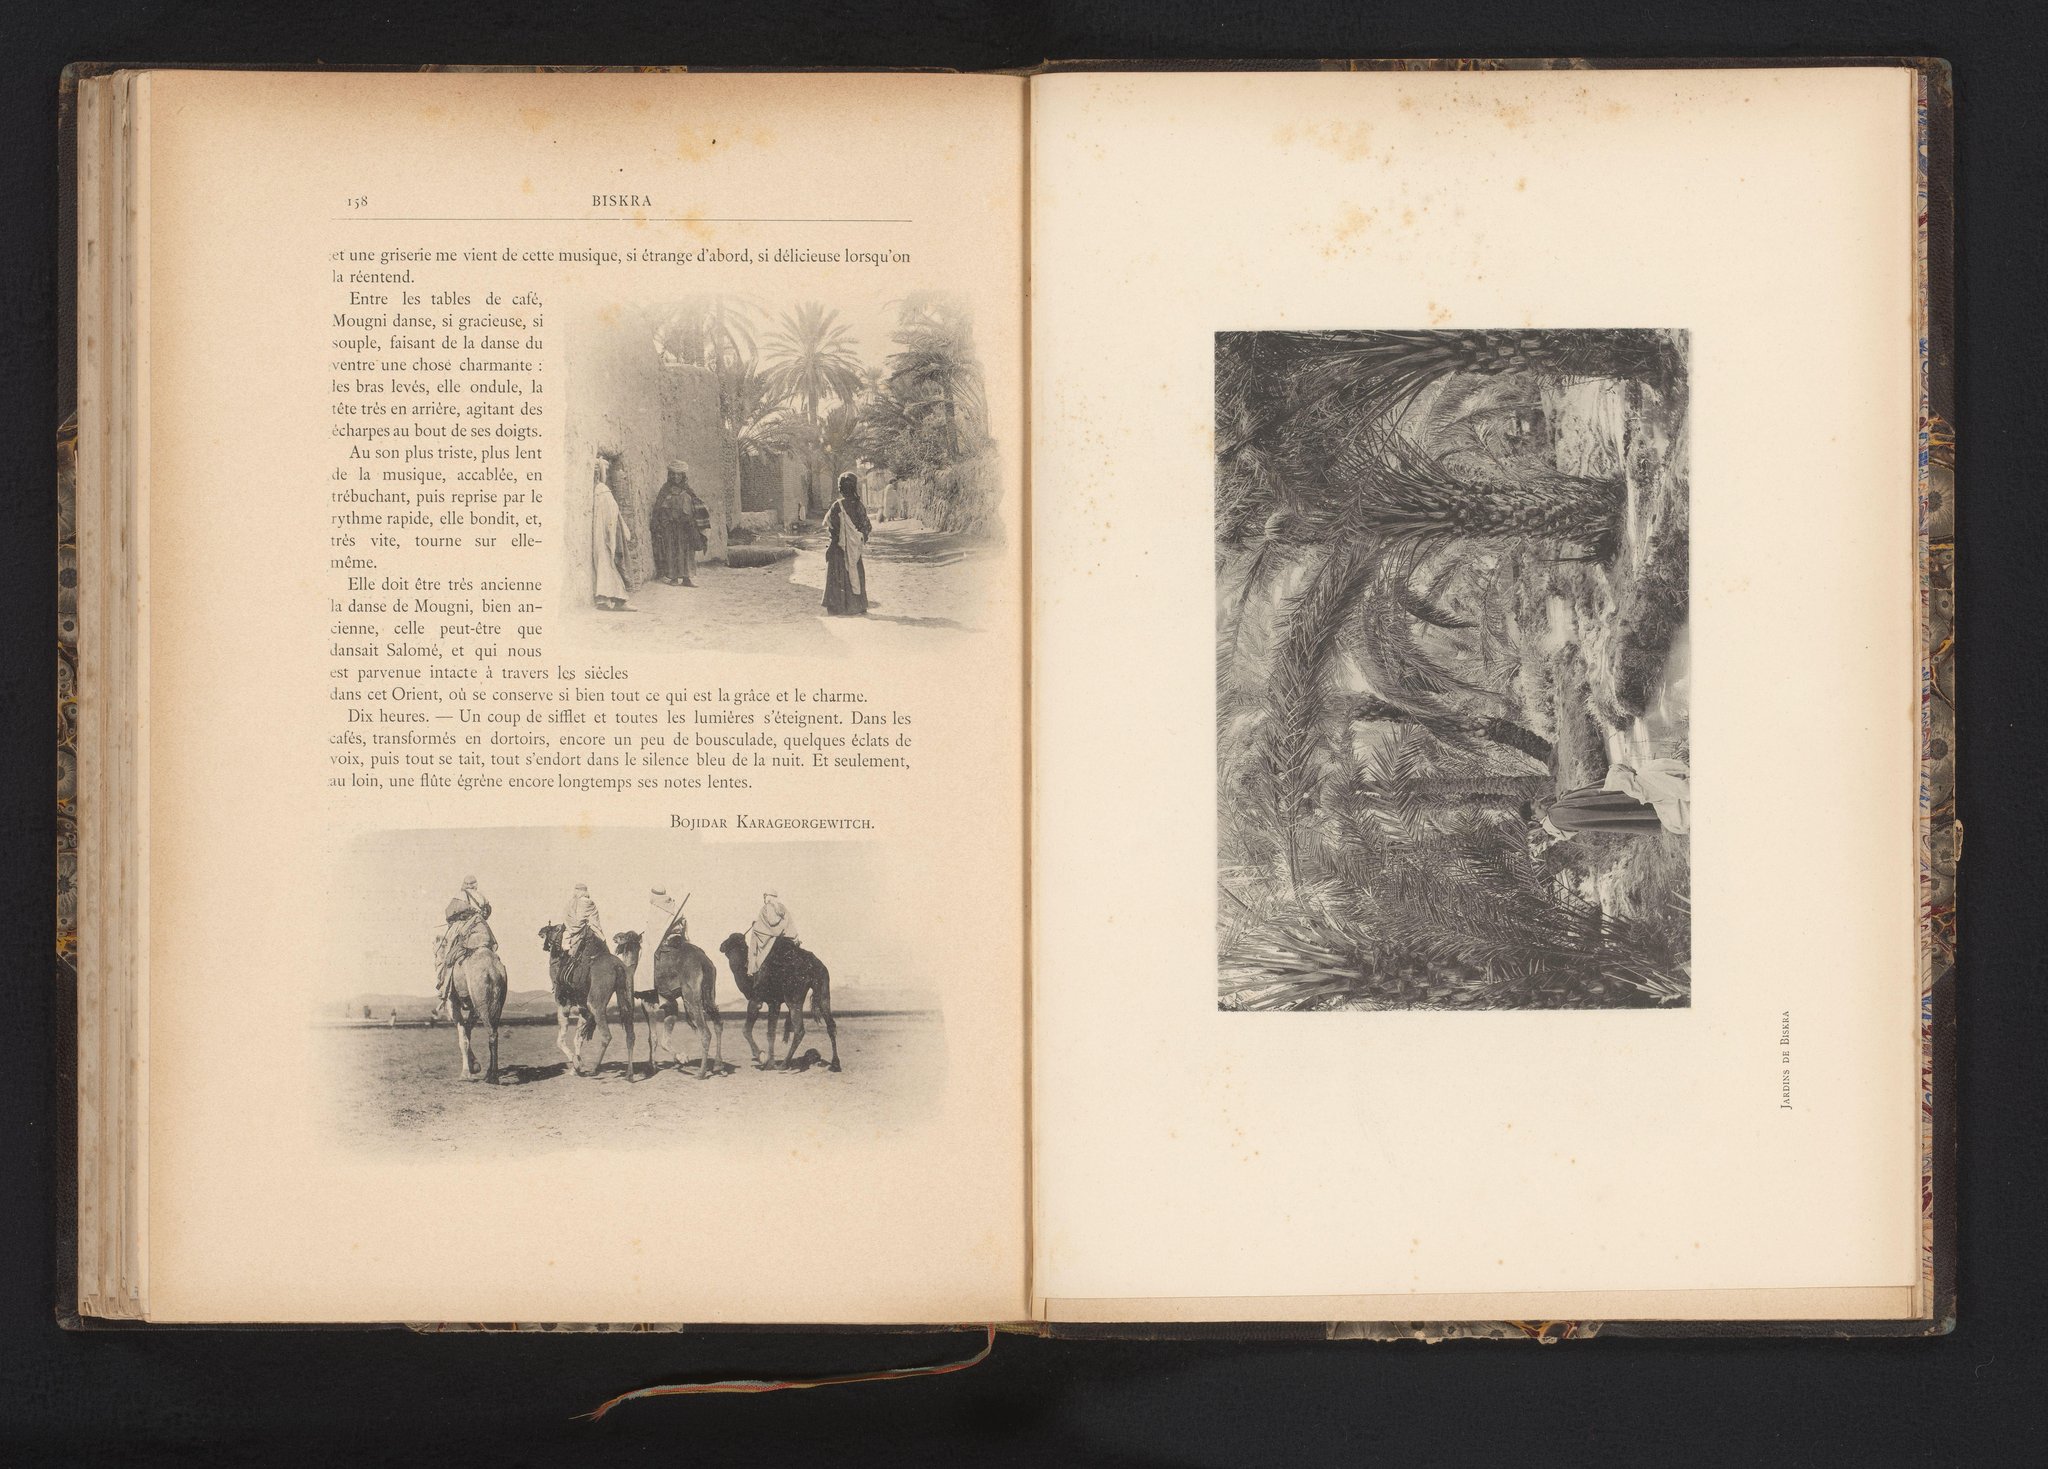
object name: page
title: Drie vrouwen op straat in Biskra, Algerije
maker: jules gervais-courtellemont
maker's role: fotograaf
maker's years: 1863-1931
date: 1888-1893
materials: paper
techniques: photograph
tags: adult woman, street